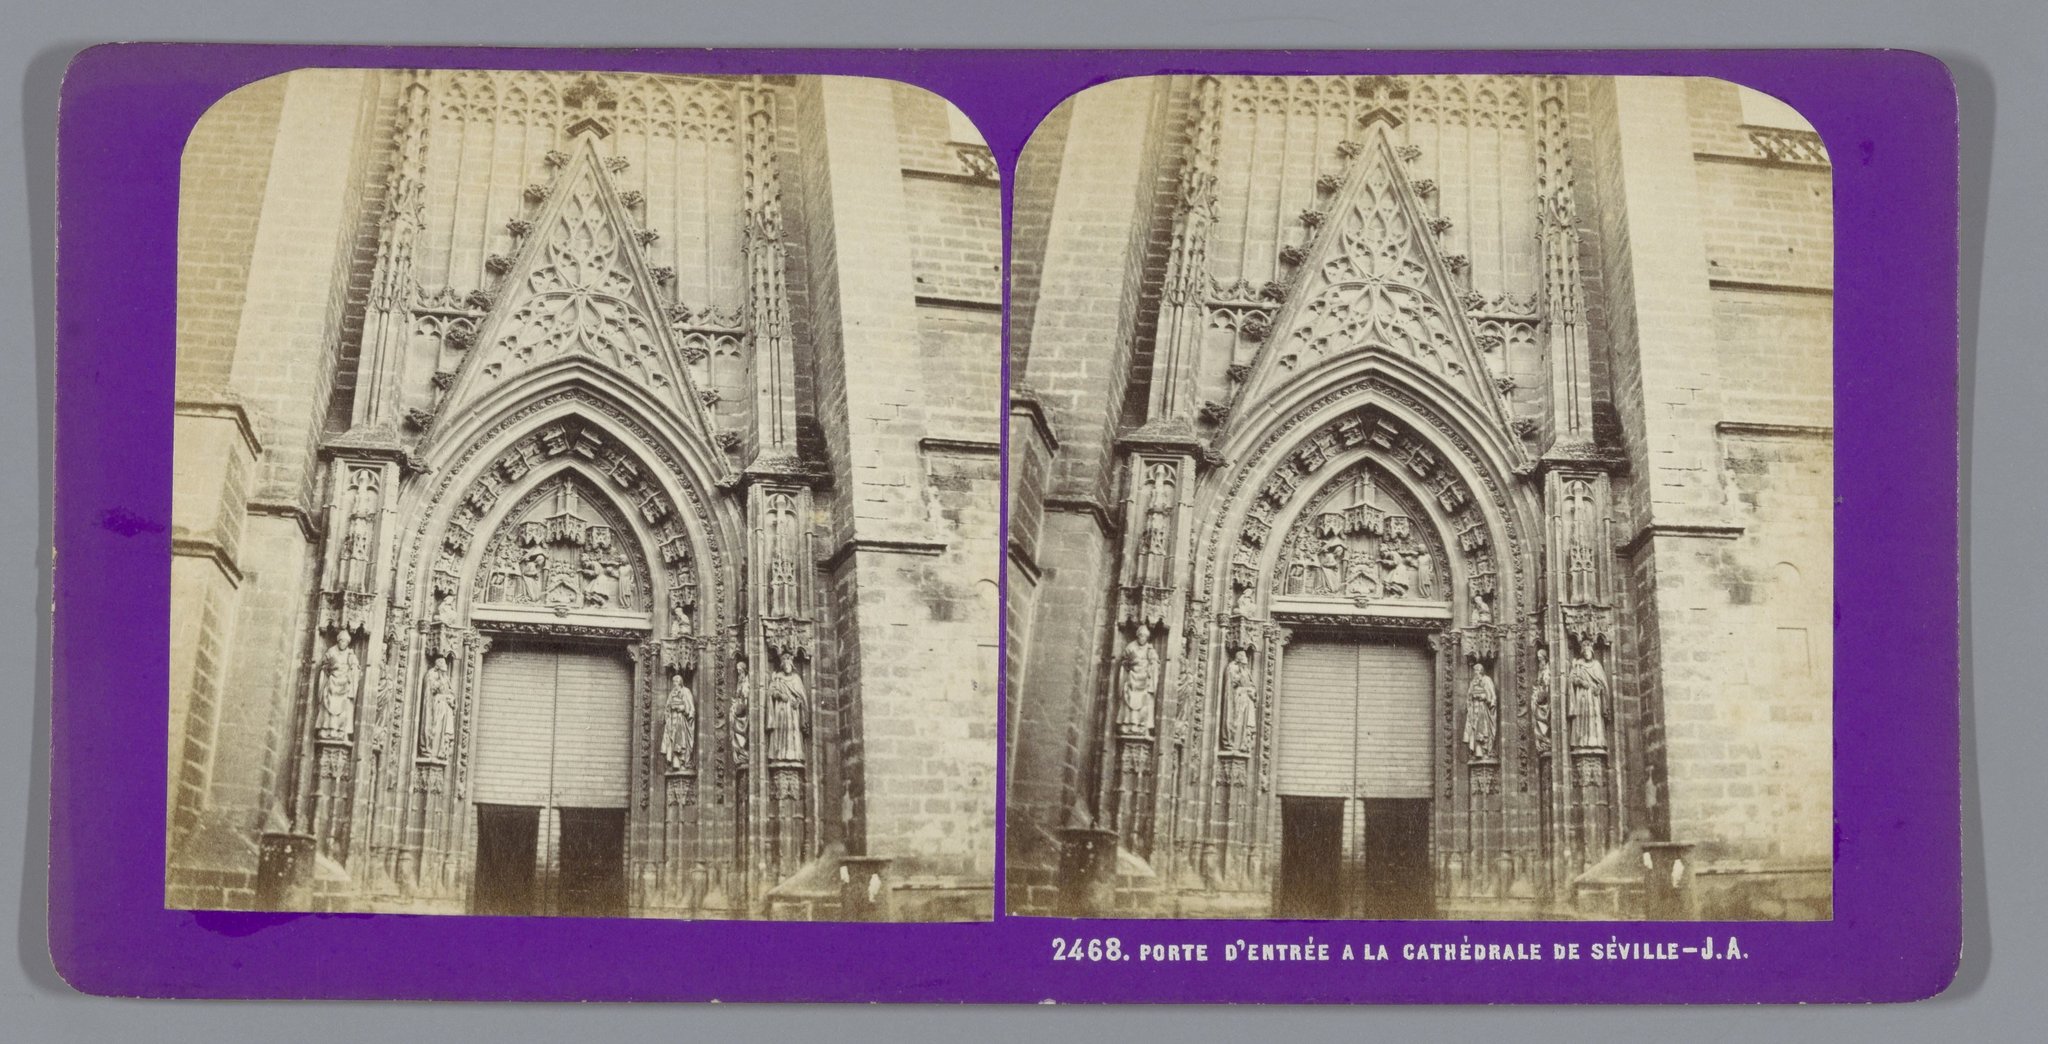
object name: stereograph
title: Porte d'entree a la Cathedrale de Seville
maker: jean andrieu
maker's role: fotograaf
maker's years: 1816-1872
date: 1862-1876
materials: cardboard, photographic support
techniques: albumen print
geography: sevilla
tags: parts of church exterior and annexes: portal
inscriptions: number: ‘2468.’